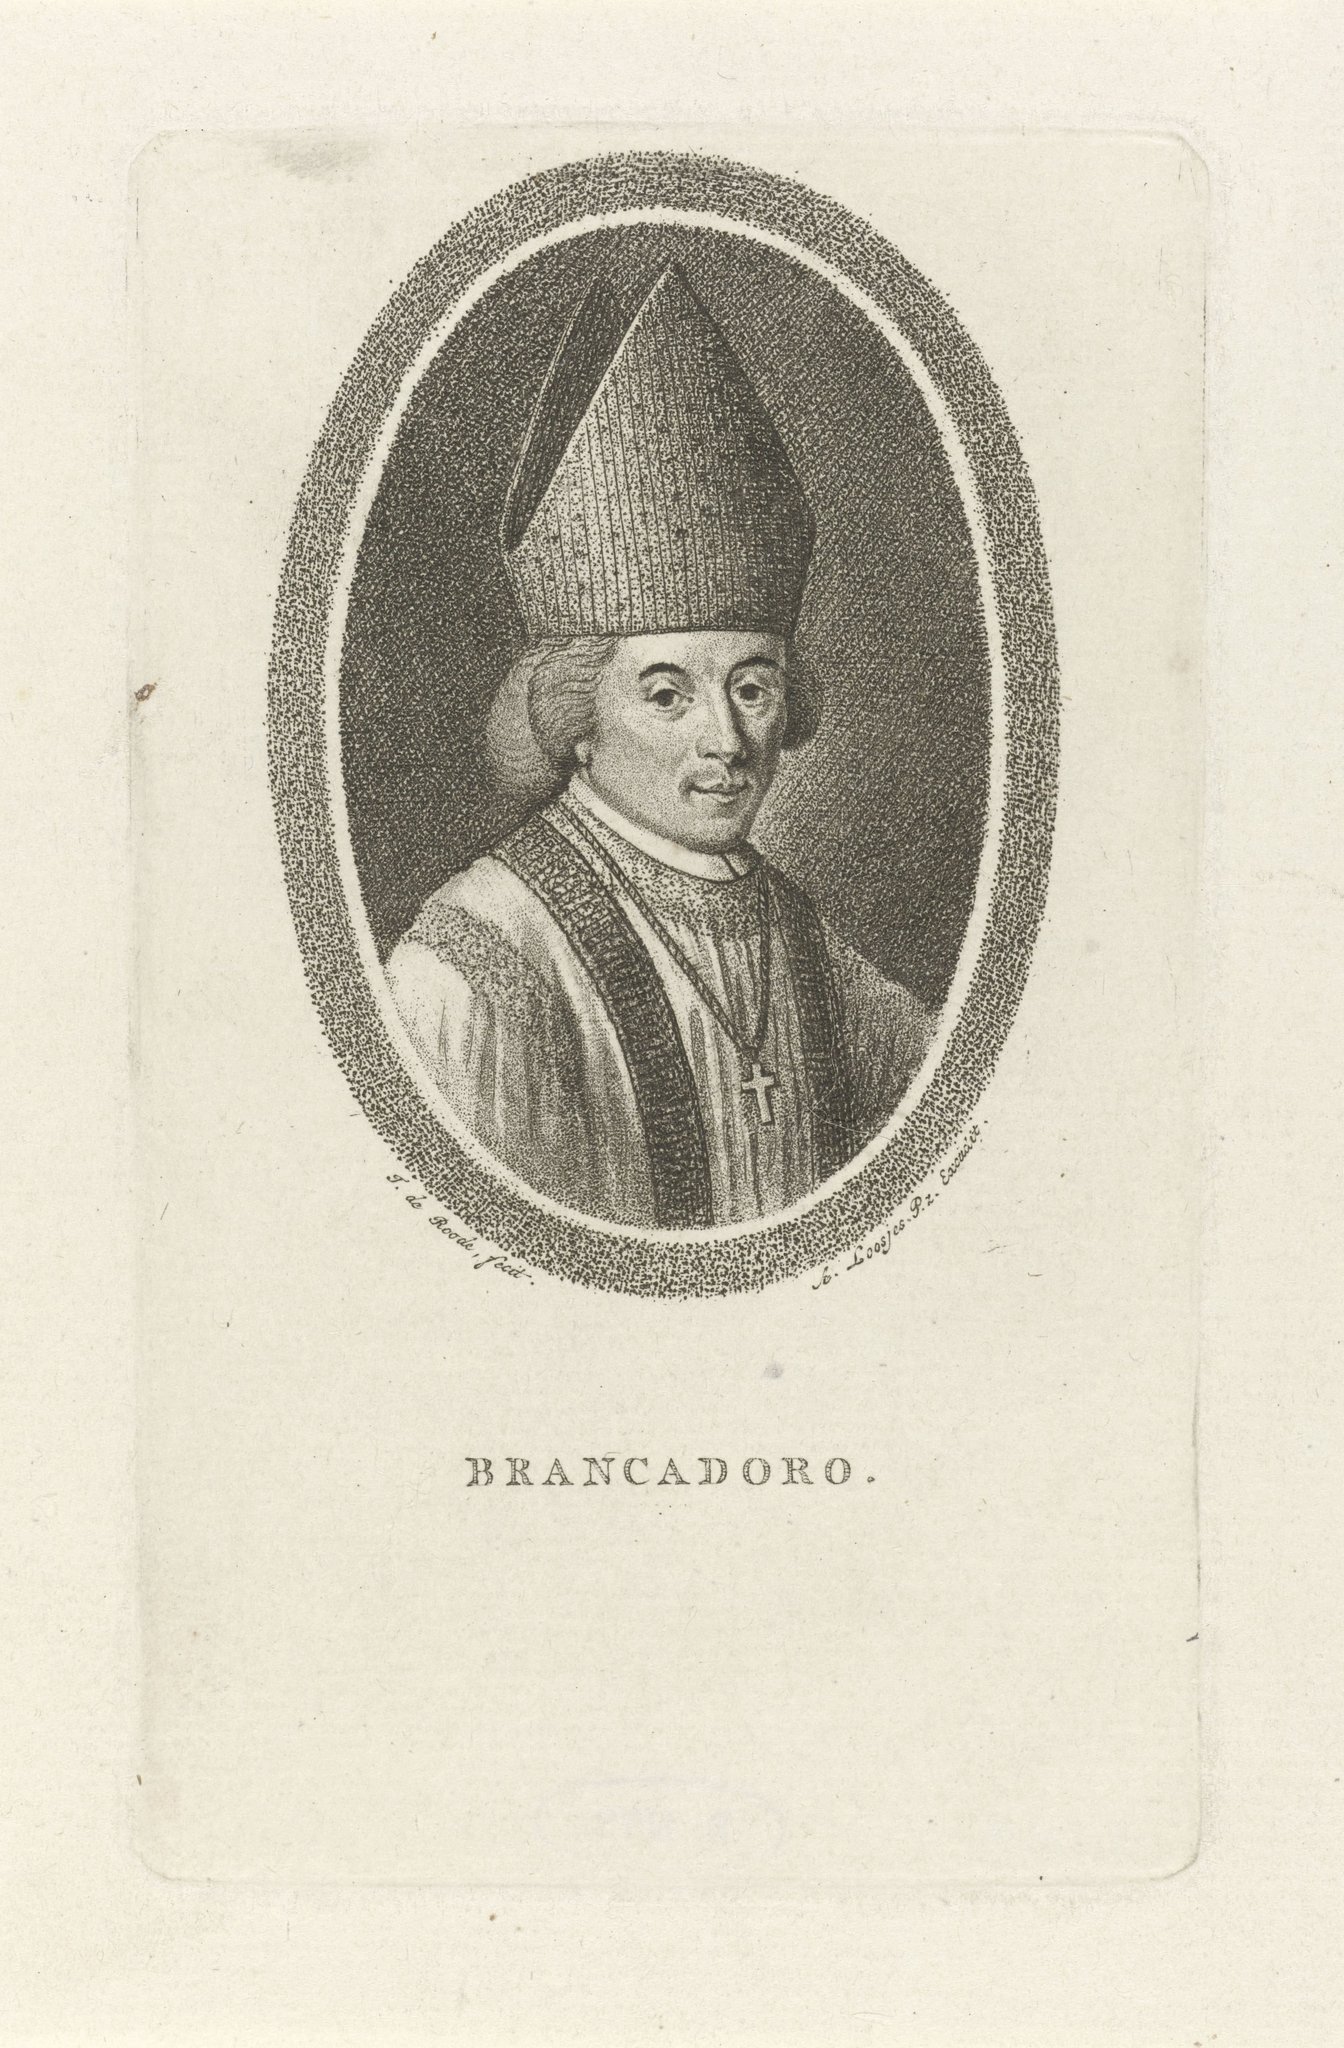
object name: print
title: Portret van Cesare Brancadoro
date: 1783-1793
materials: paper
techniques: stippled etching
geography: netherlands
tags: rome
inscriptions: collector's mark: Lugt 2228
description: Portret van de aartsbisschop van Nisibi, Cesare Brancadoro, graaf van Lignano. Hij draagt een mijter op zijn hoofd.